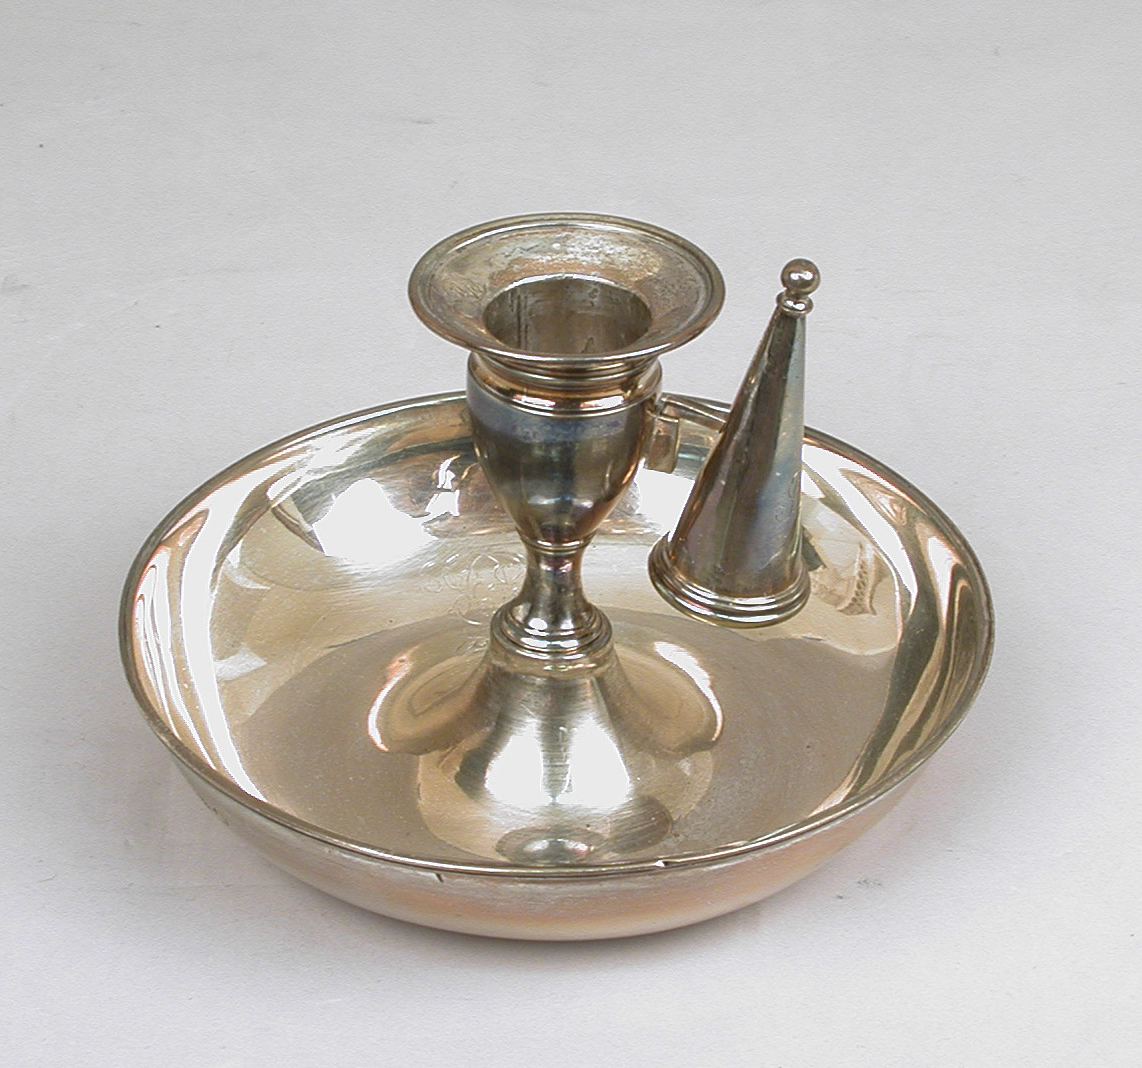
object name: chamber candlestick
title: Chamber candlestick (one of a pair)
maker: john mewburn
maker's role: maker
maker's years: 1750-1850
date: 1805-1806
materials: silver